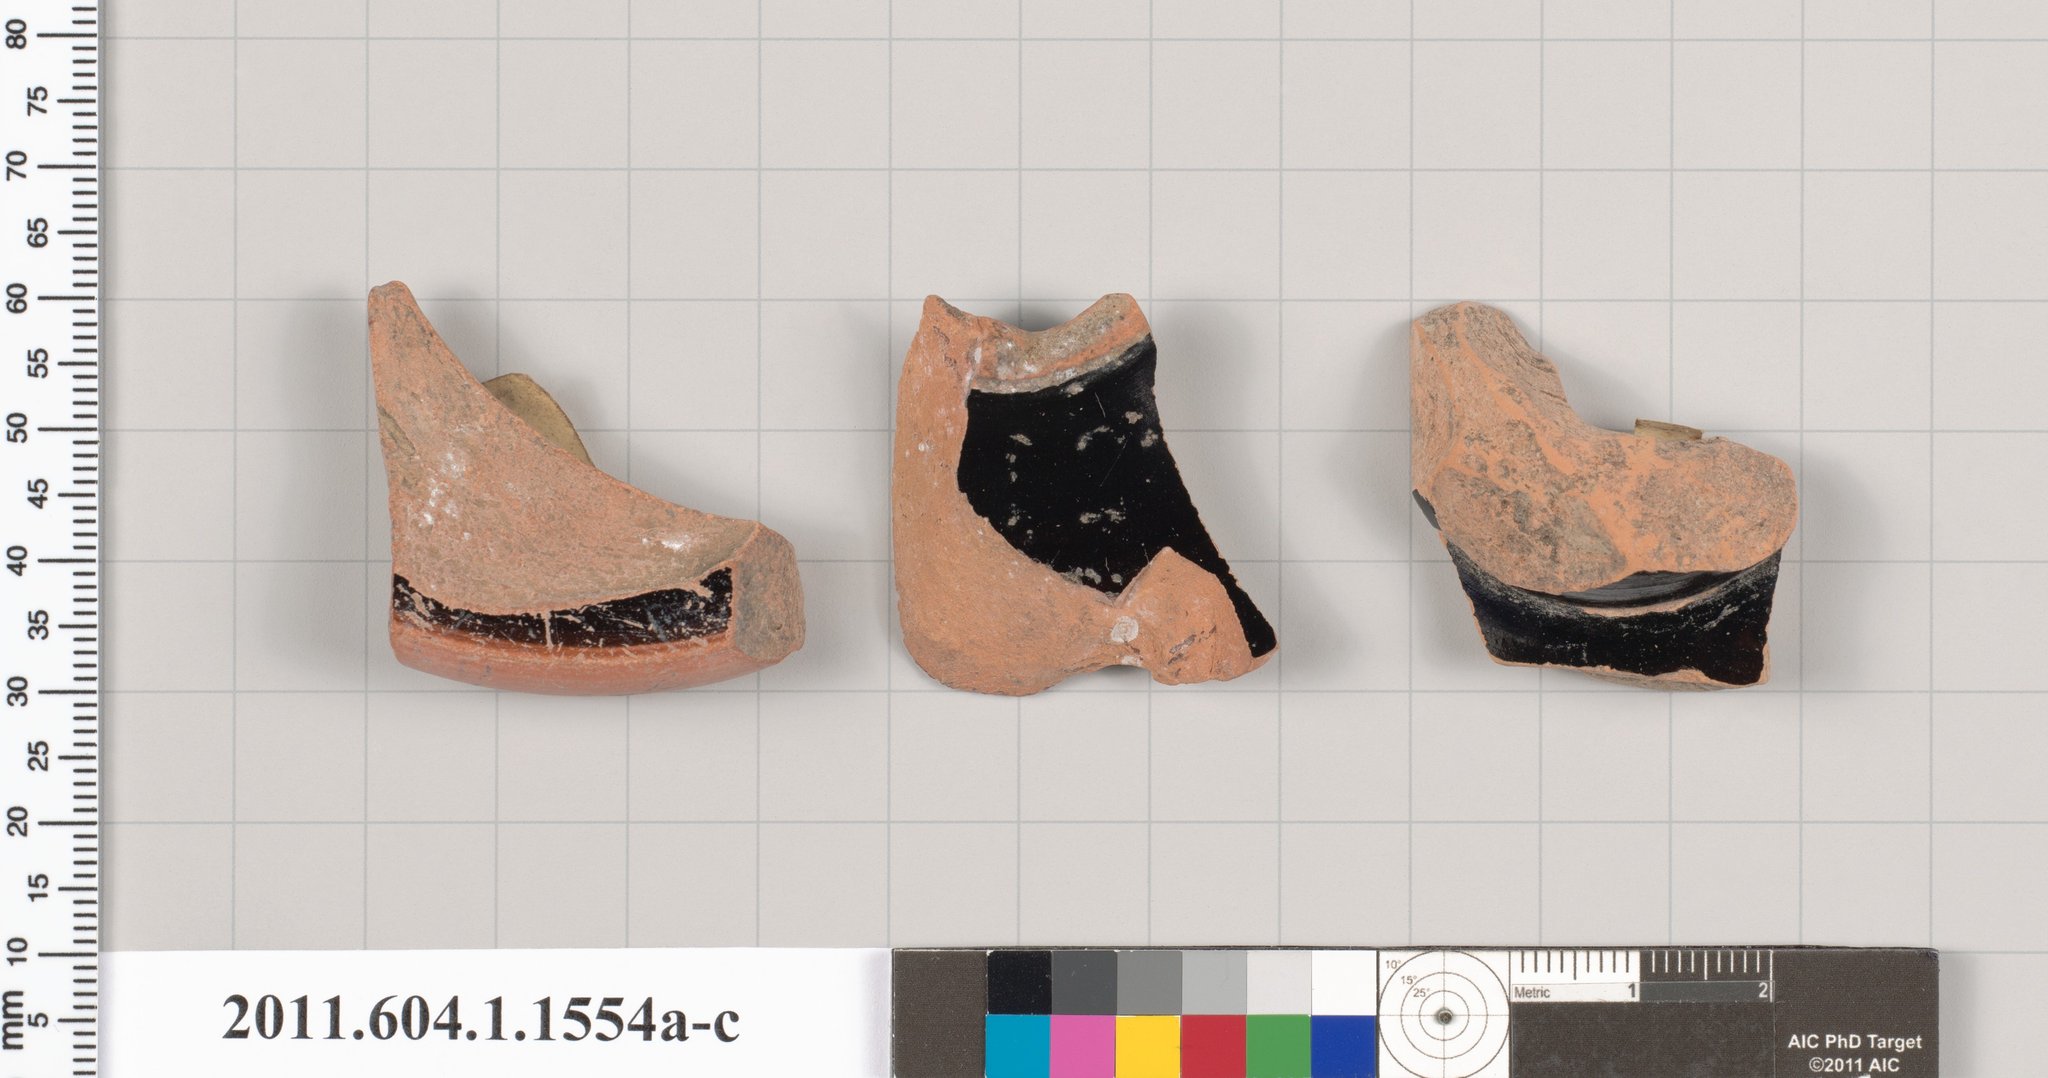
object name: kylix fragment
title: Terracotta fragments of kylikes (drinking cups)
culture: greek, attic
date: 500-401 BCE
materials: terracotta